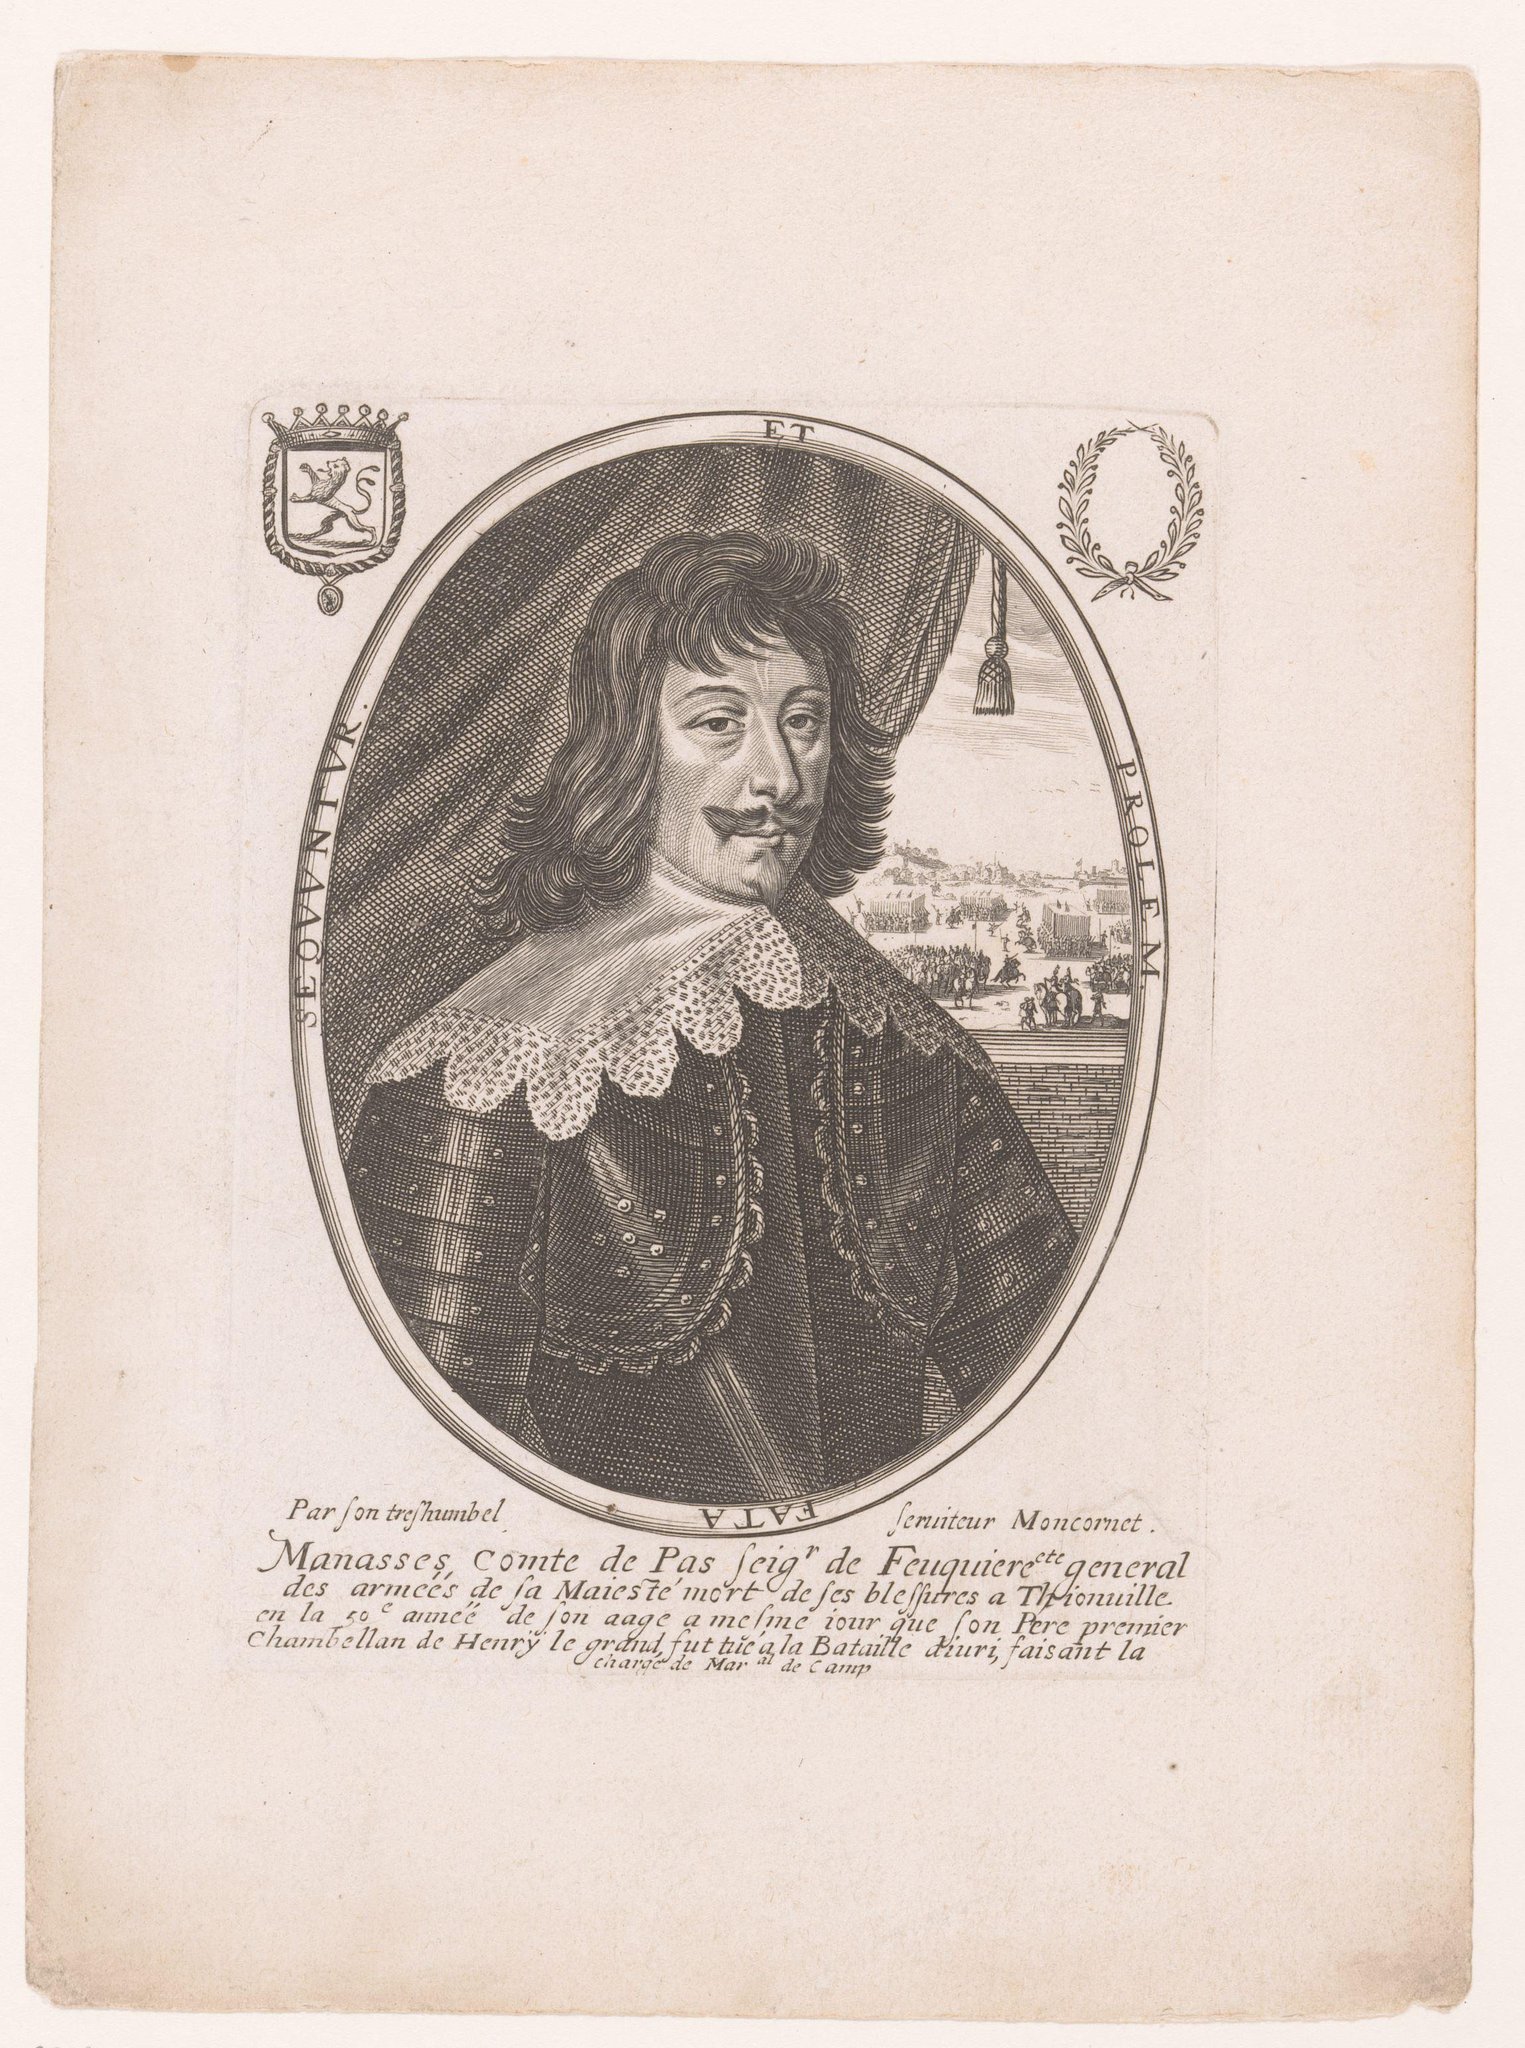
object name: print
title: Portret van Manassès de Pas de Feuquières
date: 1630-1668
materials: paper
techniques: engraving, etching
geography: paris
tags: historical persons, armorial bearing, heraldry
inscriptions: collector's mark: Lugt 2228